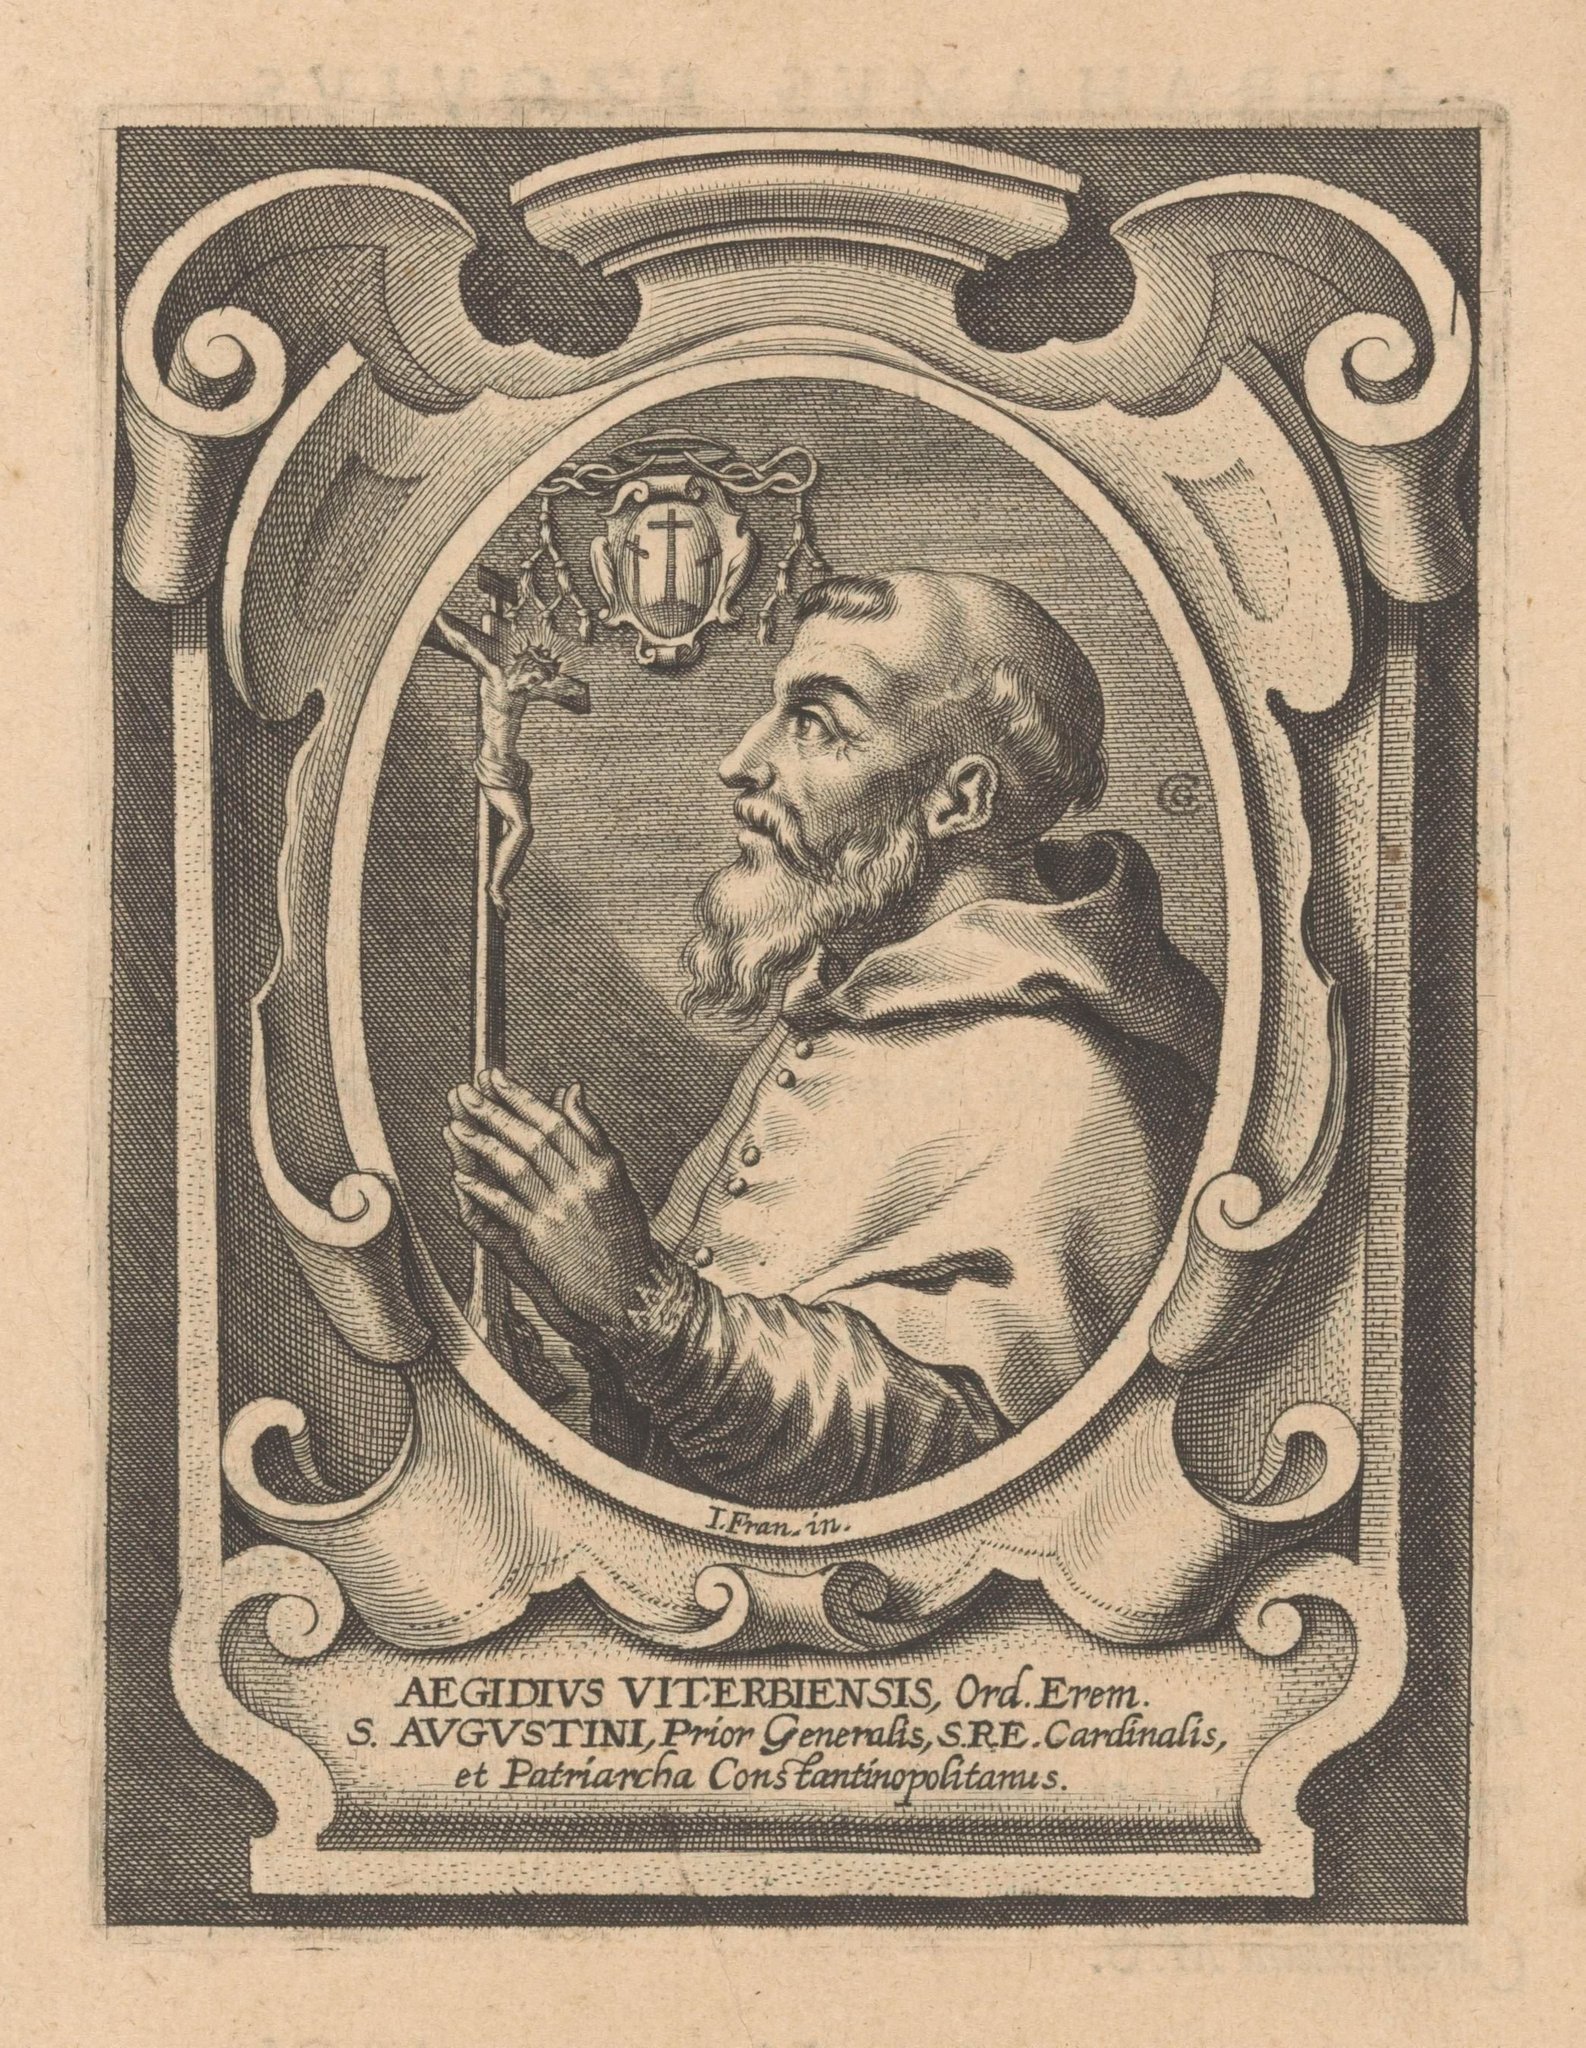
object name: book illustration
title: Portret van Aegidius Antonius Canisius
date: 1636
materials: paper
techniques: engraving, letterpress printing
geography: antwerp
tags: viterbo, kardinaal, bisschop, aegidius antonius canisius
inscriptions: collector's mark: Lugt 2228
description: Portret van Aegidius Antonius Canisius in een geornamenteerde, ovale omlijsting. Hij heeft zijn handen gevouwen voor een crucifix. Midden boven een wapen met drie kruizen. In een kader zijn naam en titels.